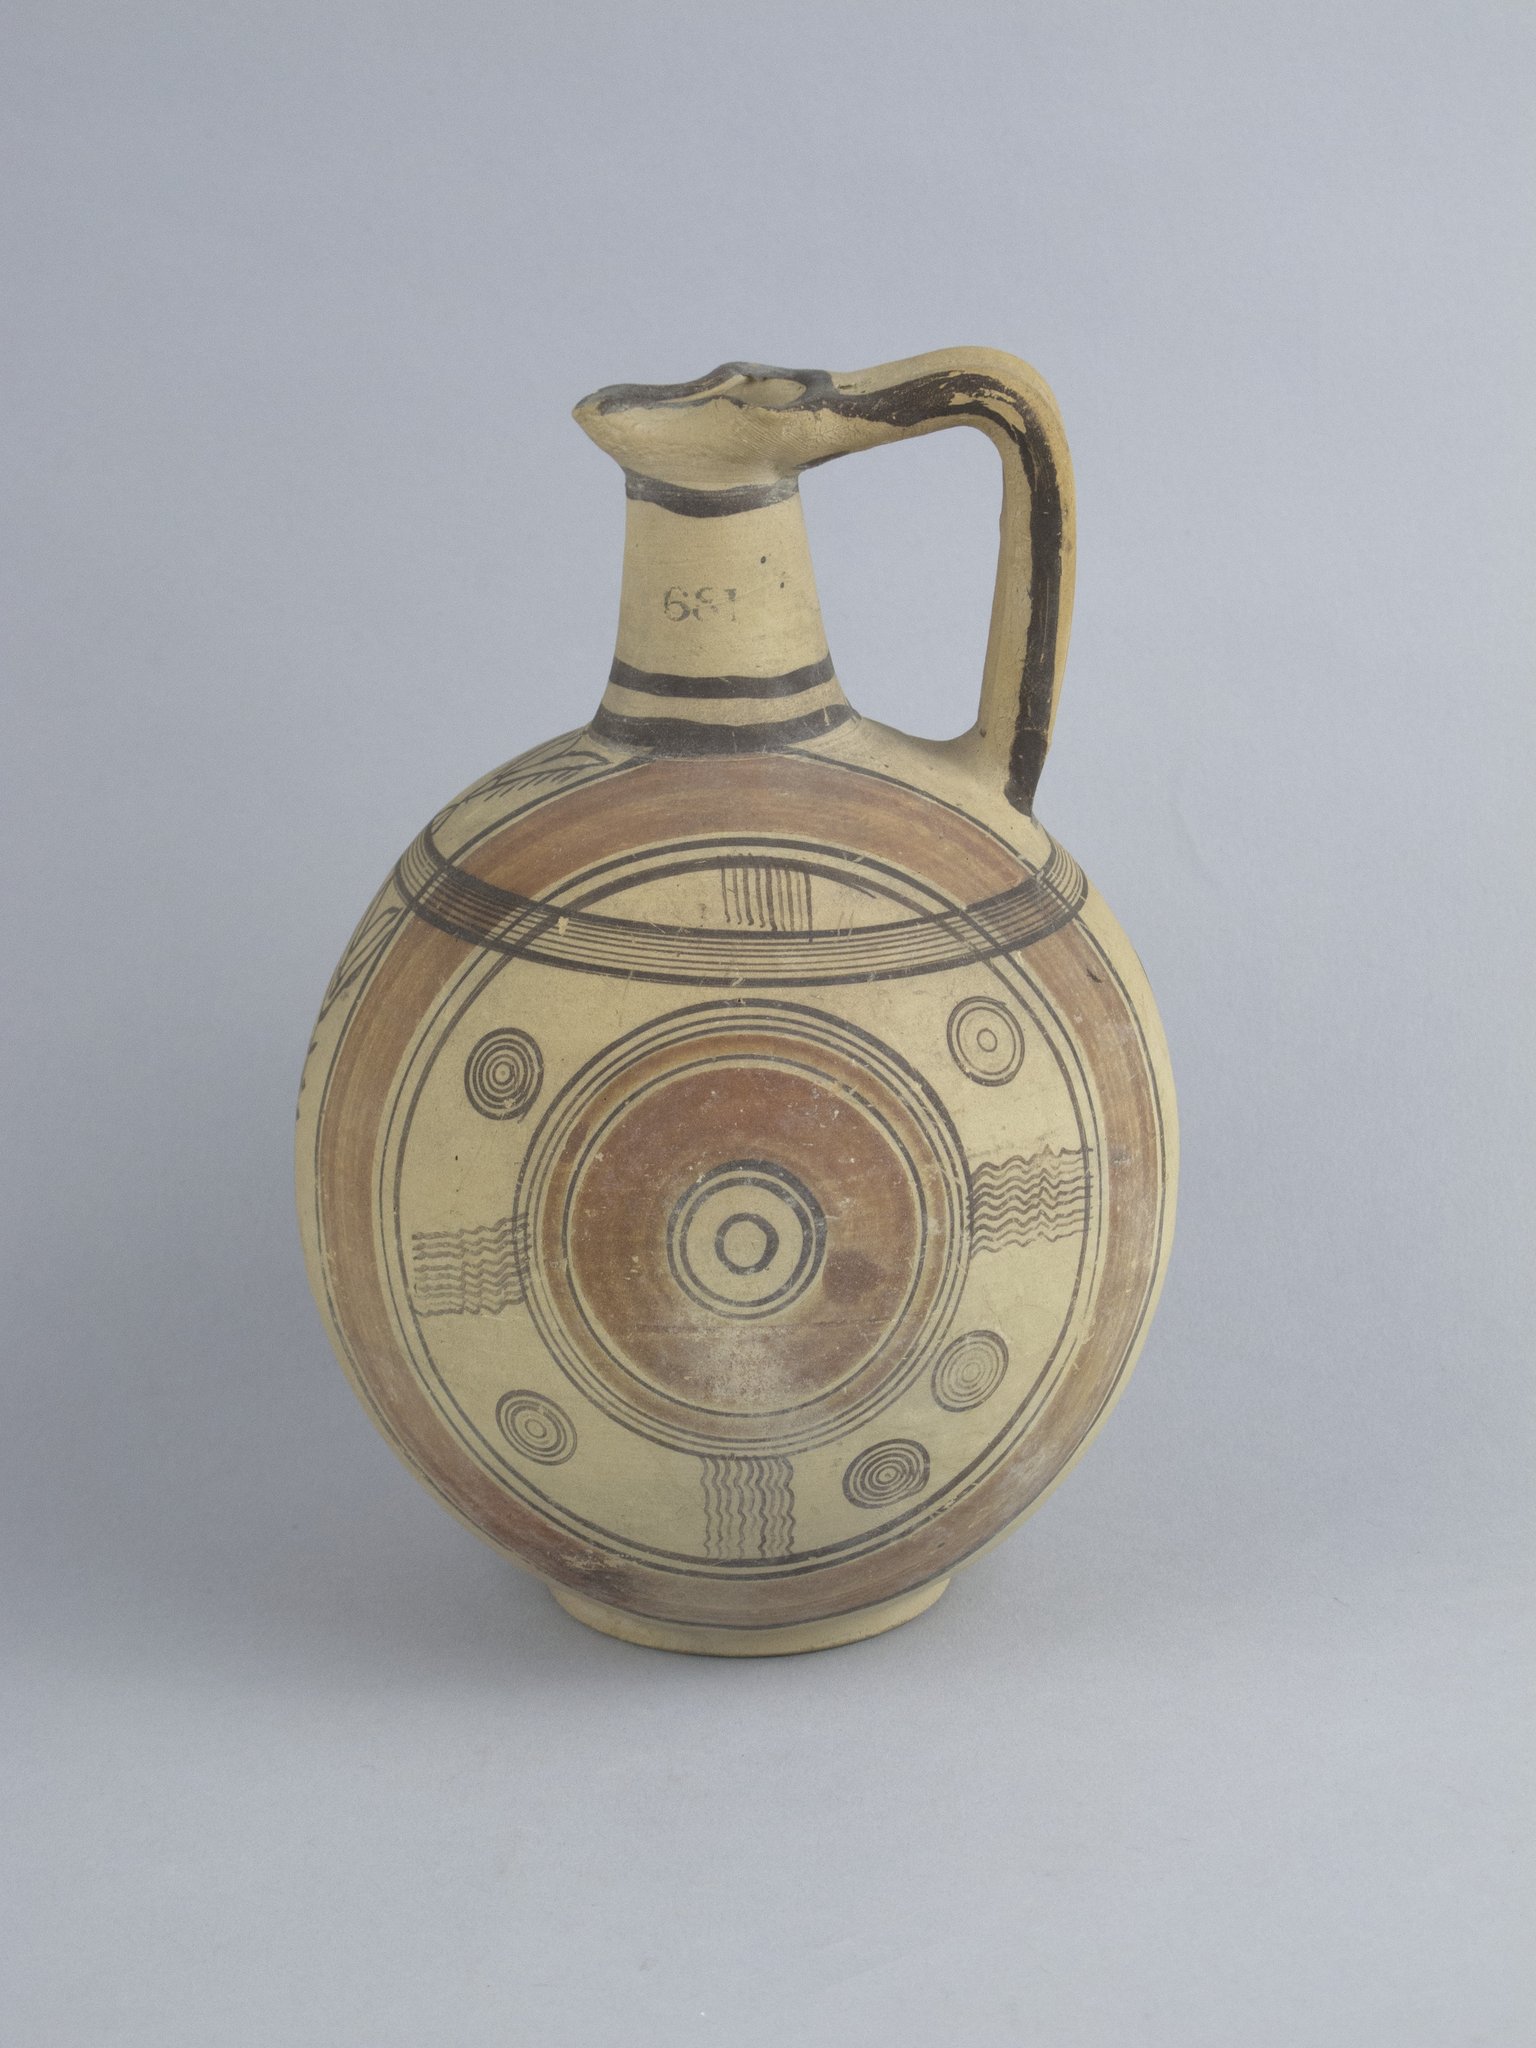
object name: jug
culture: cypriot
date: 600-480 BCE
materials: terracotta